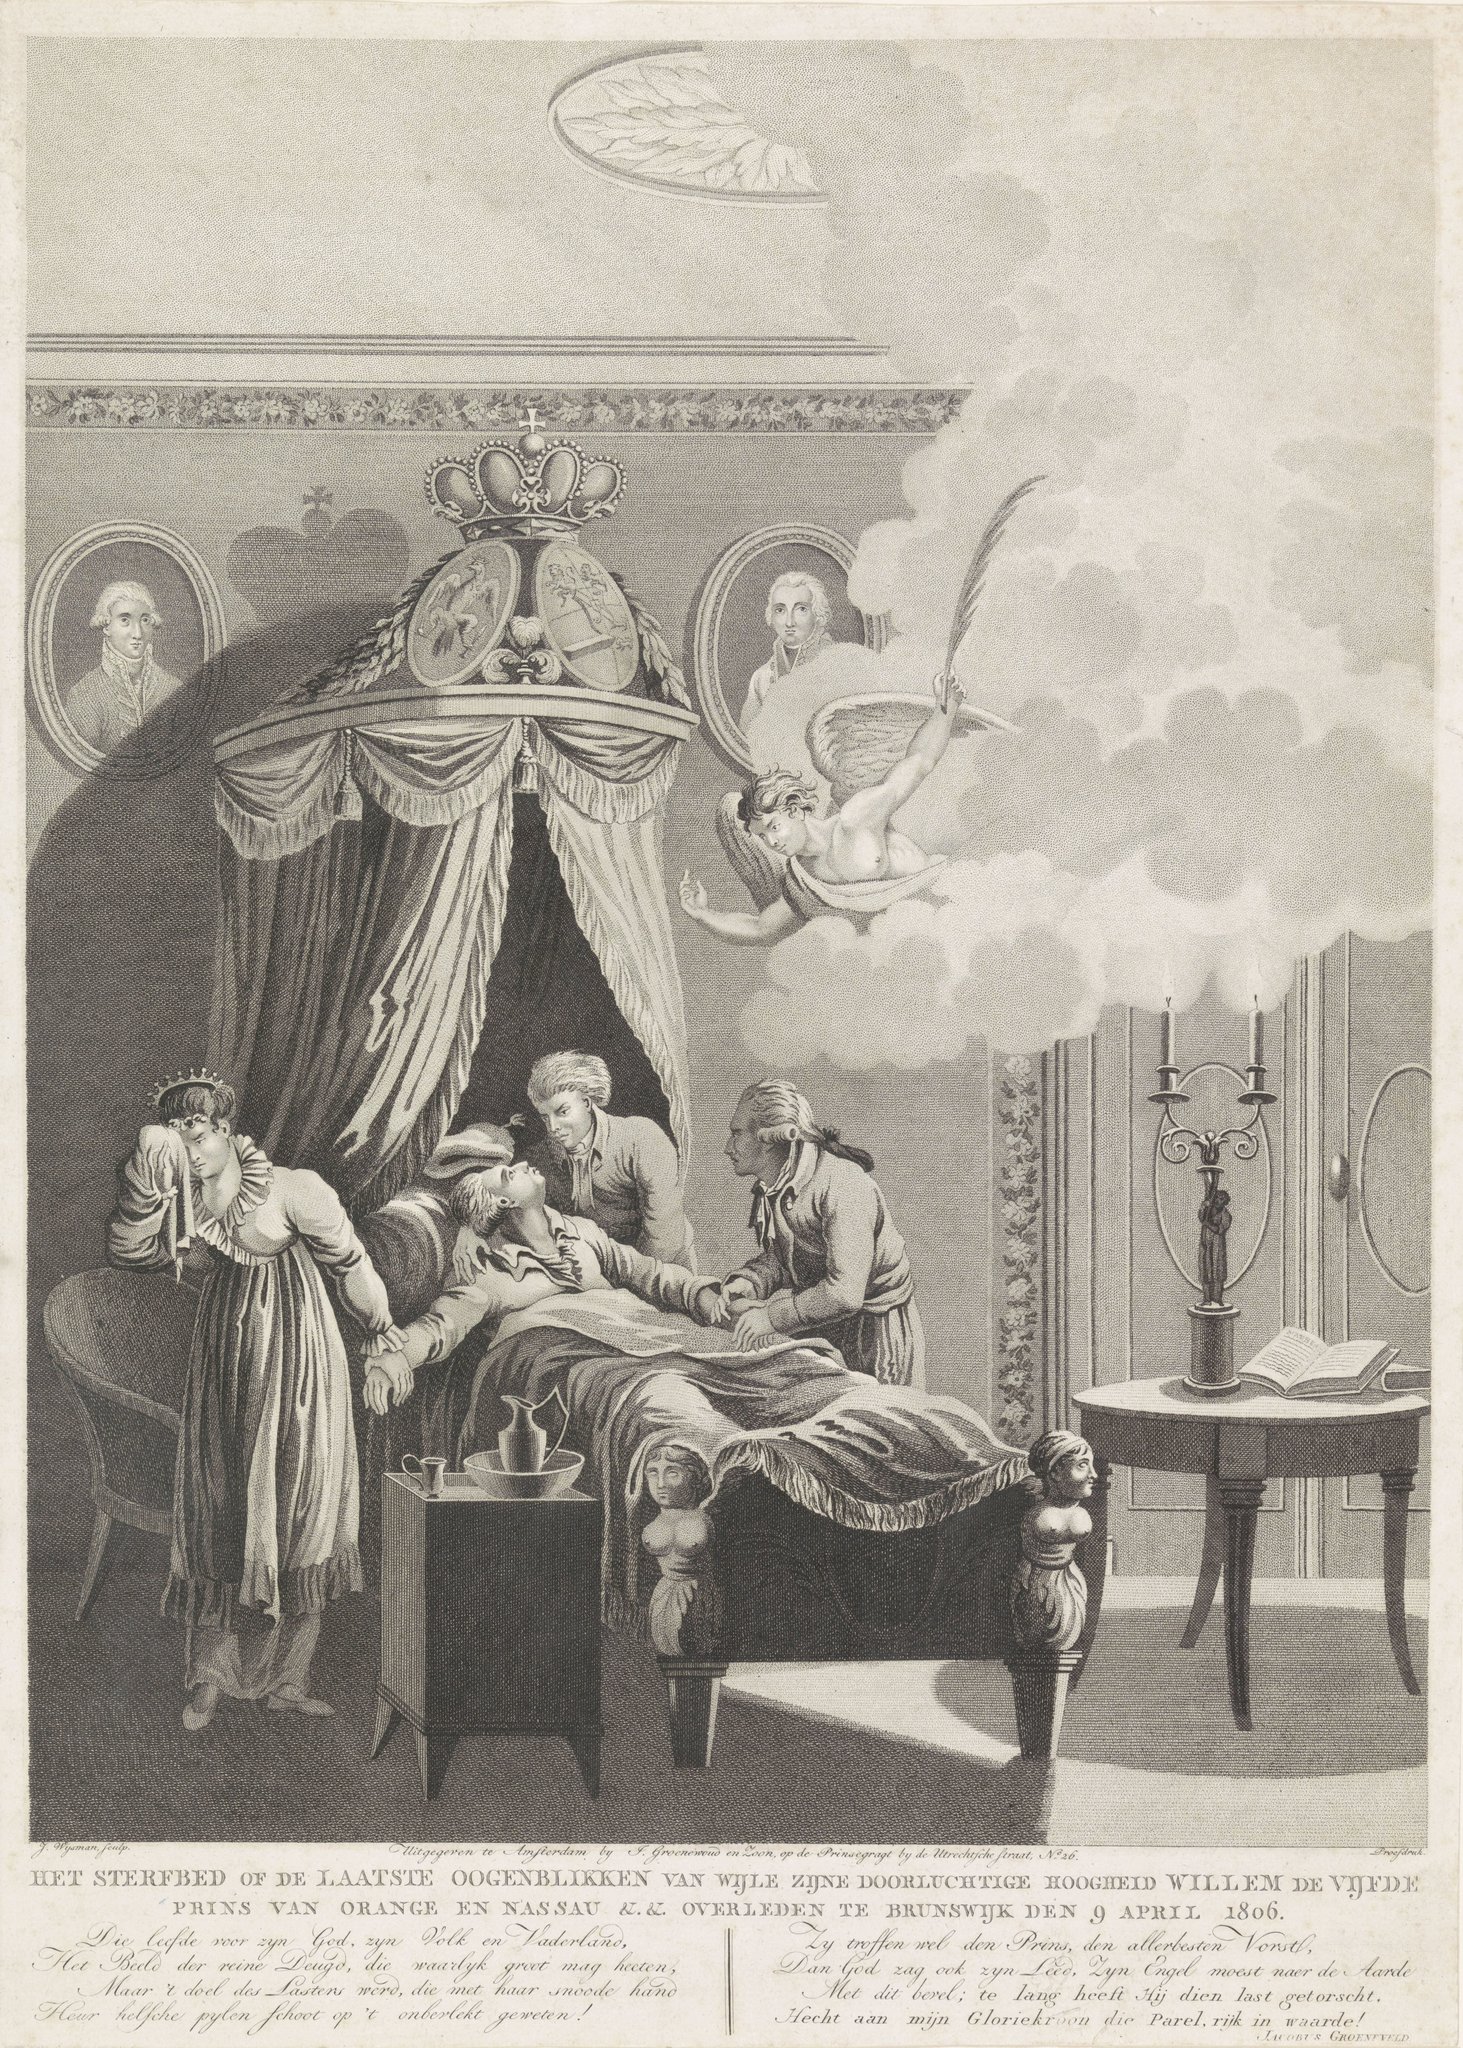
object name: print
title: Het sterfbed of de laatste oogenblikken van wijle zijn doorluchtige hoogheid Willem de Vijfde (...) overleden te Brunswijk den 9 april 1806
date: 1806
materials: paper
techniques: engraving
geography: netherlands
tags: the hague, william v (prince of orange), berlin, painter, draughtsman, wilhelmina of prussia (princess of orange), deathbed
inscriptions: collector's mark: Lugt 2228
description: Slaapkamer met prins Willem V op zijn sterfbed, ondersteund door zijn kamerheer (Vleeshouwer), 9 april 1806. De geneesheer voelt de linkerpols terwijl zijn echtgenote met afgewend gezicht zijn rechterhand vasthoudt. In de lucht een engel met palmtak in wolken. Hemelbed versierd met de wapens van de prins en prinses, aan de wand portretten van de twee zoons van de prins. In het onderschrift een achtregelig vers. Bij de prent behoort een bericht van intekening. Uitgegeven als pendant van de prent met het monument voor Willem V.